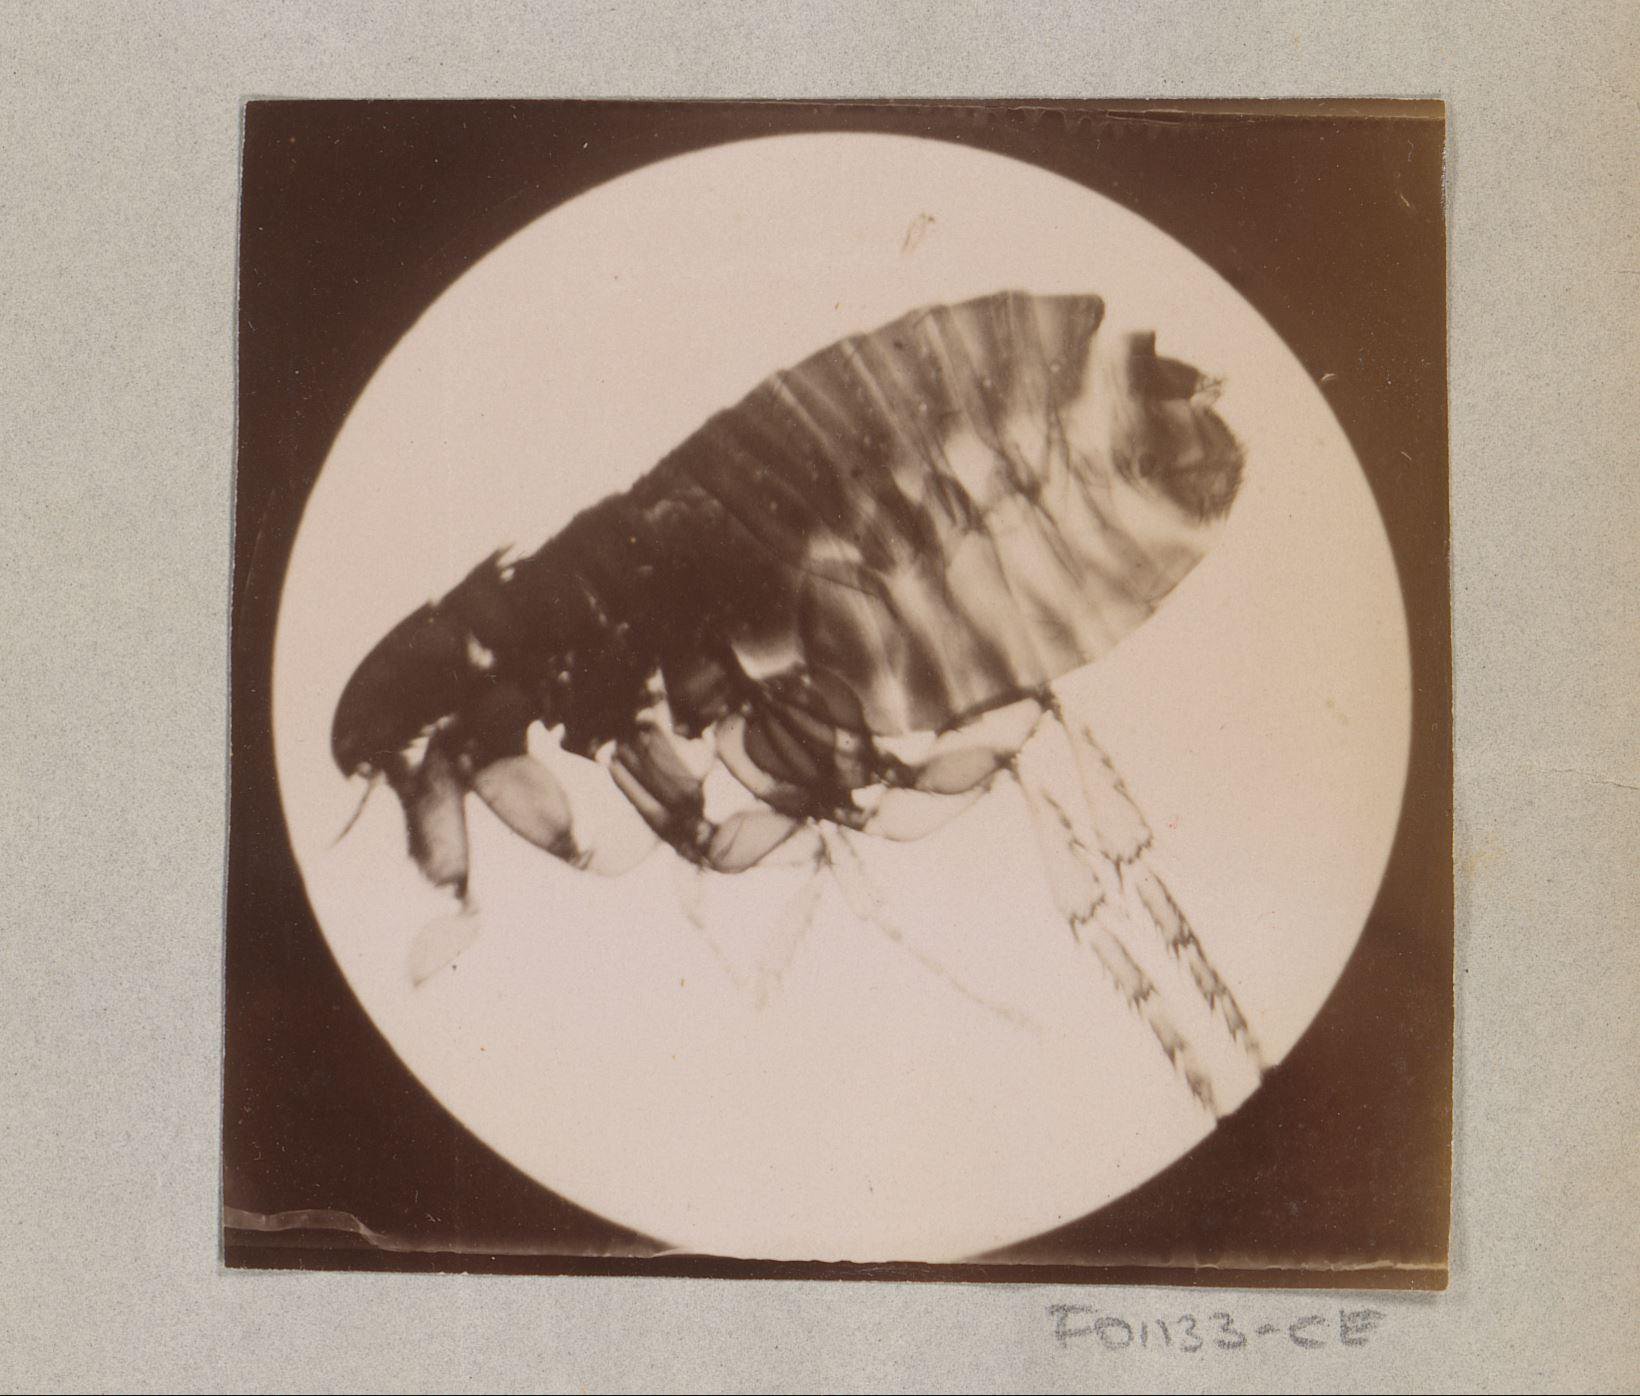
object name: photograph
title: Microscopische opname van een vlo, 25 keer vergroot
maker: marinus pieter filbri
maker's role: instrument maker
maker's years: 1852-1917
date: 1887-1888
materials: paper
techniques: albumen print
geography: netherlands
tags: insects: flea, netherlands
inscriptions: inscription: ‘Studie voor pose bij een wetenschappelijk/ onderwerp’